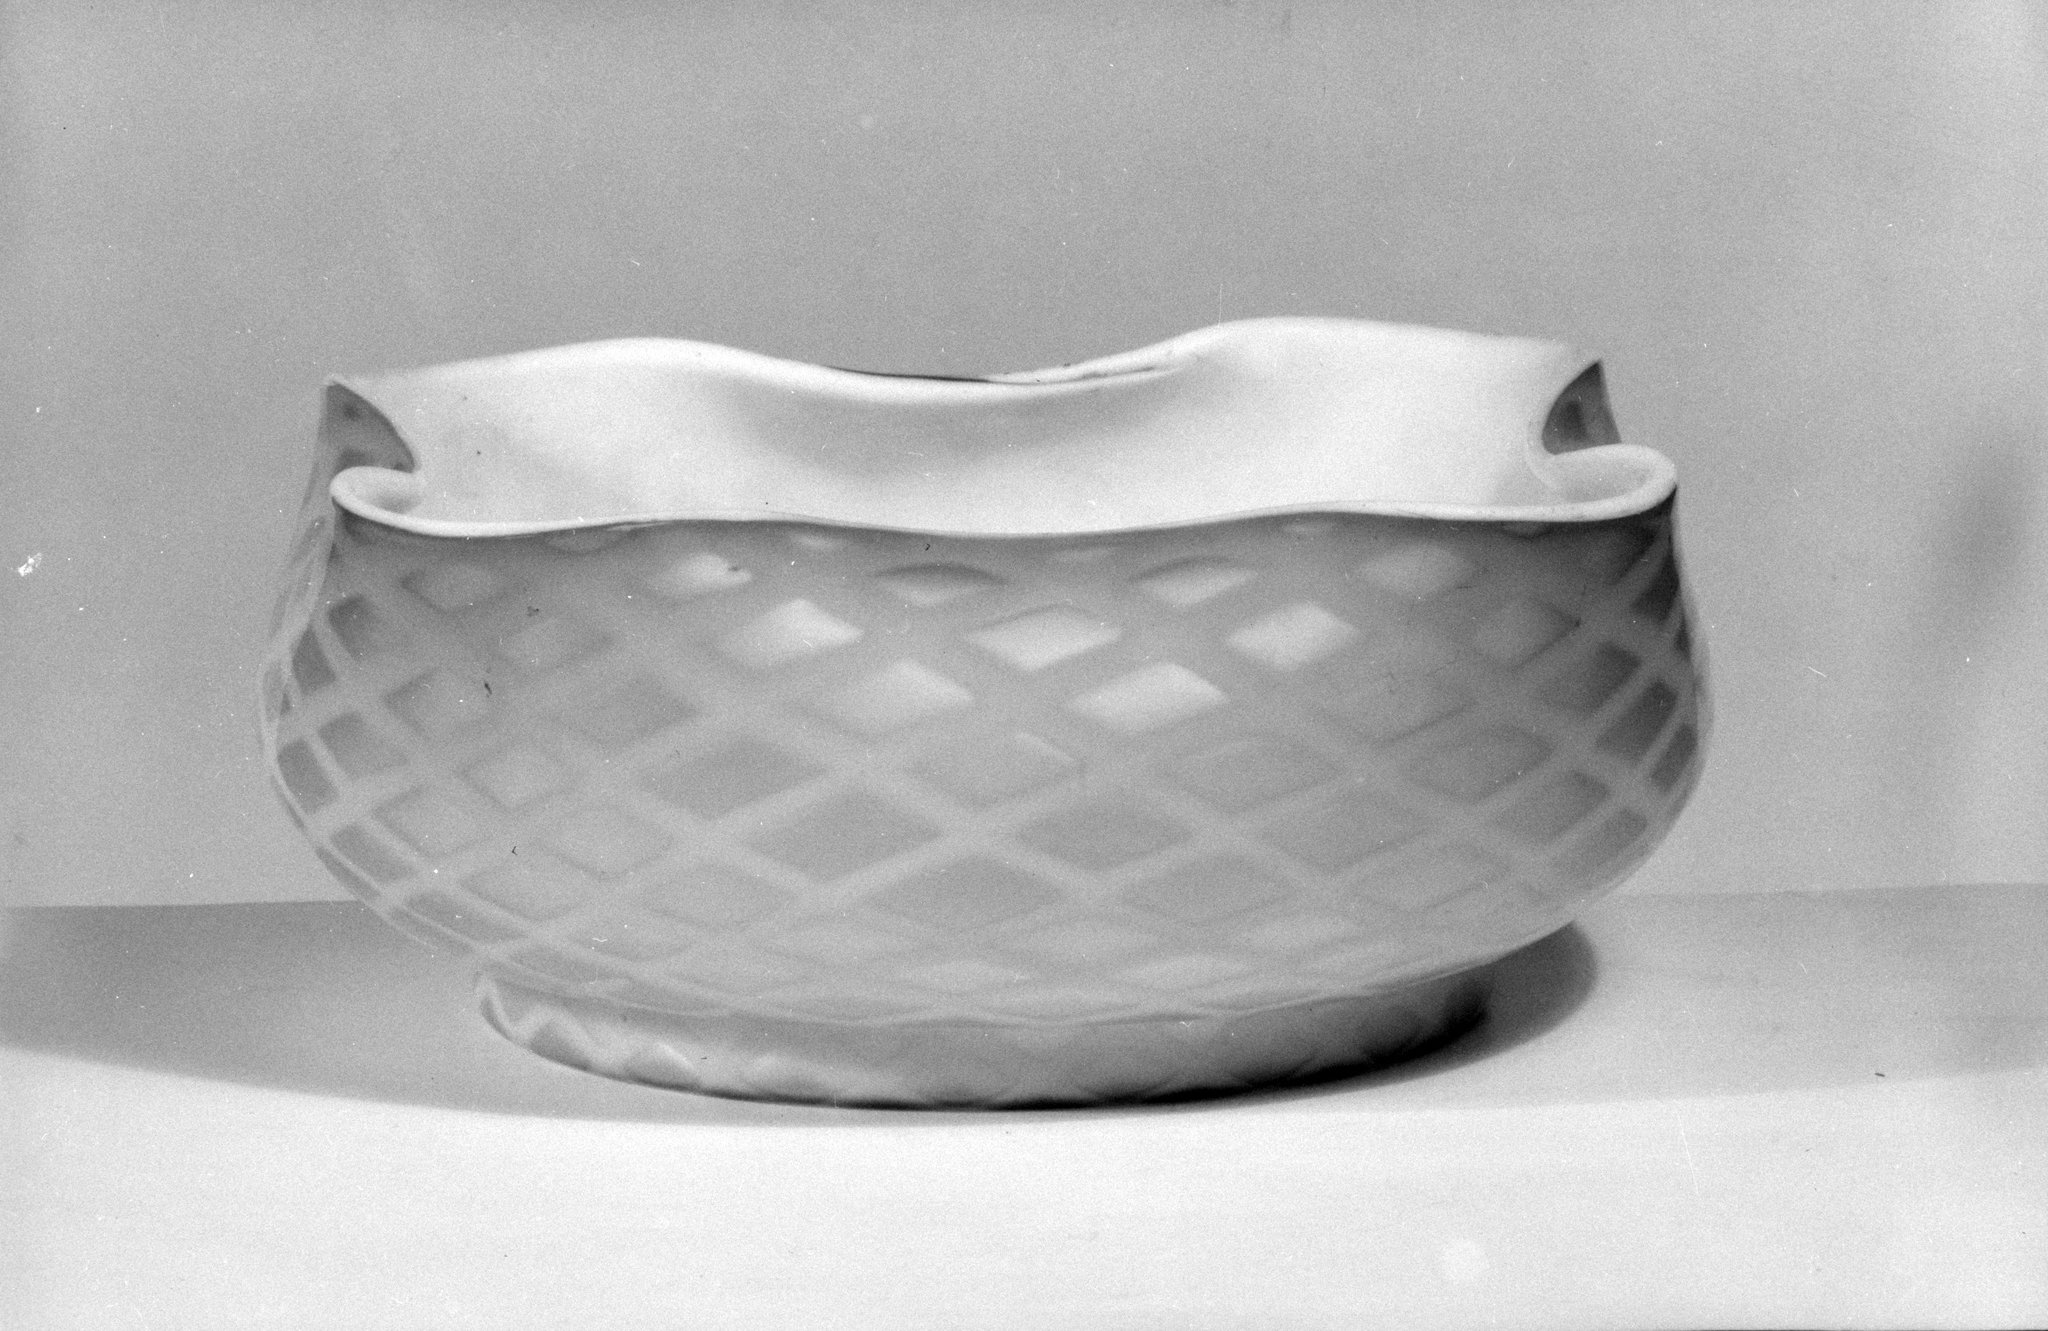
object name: bowl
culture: american or british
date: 1885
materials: glass, textile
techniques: glassblowing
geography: england